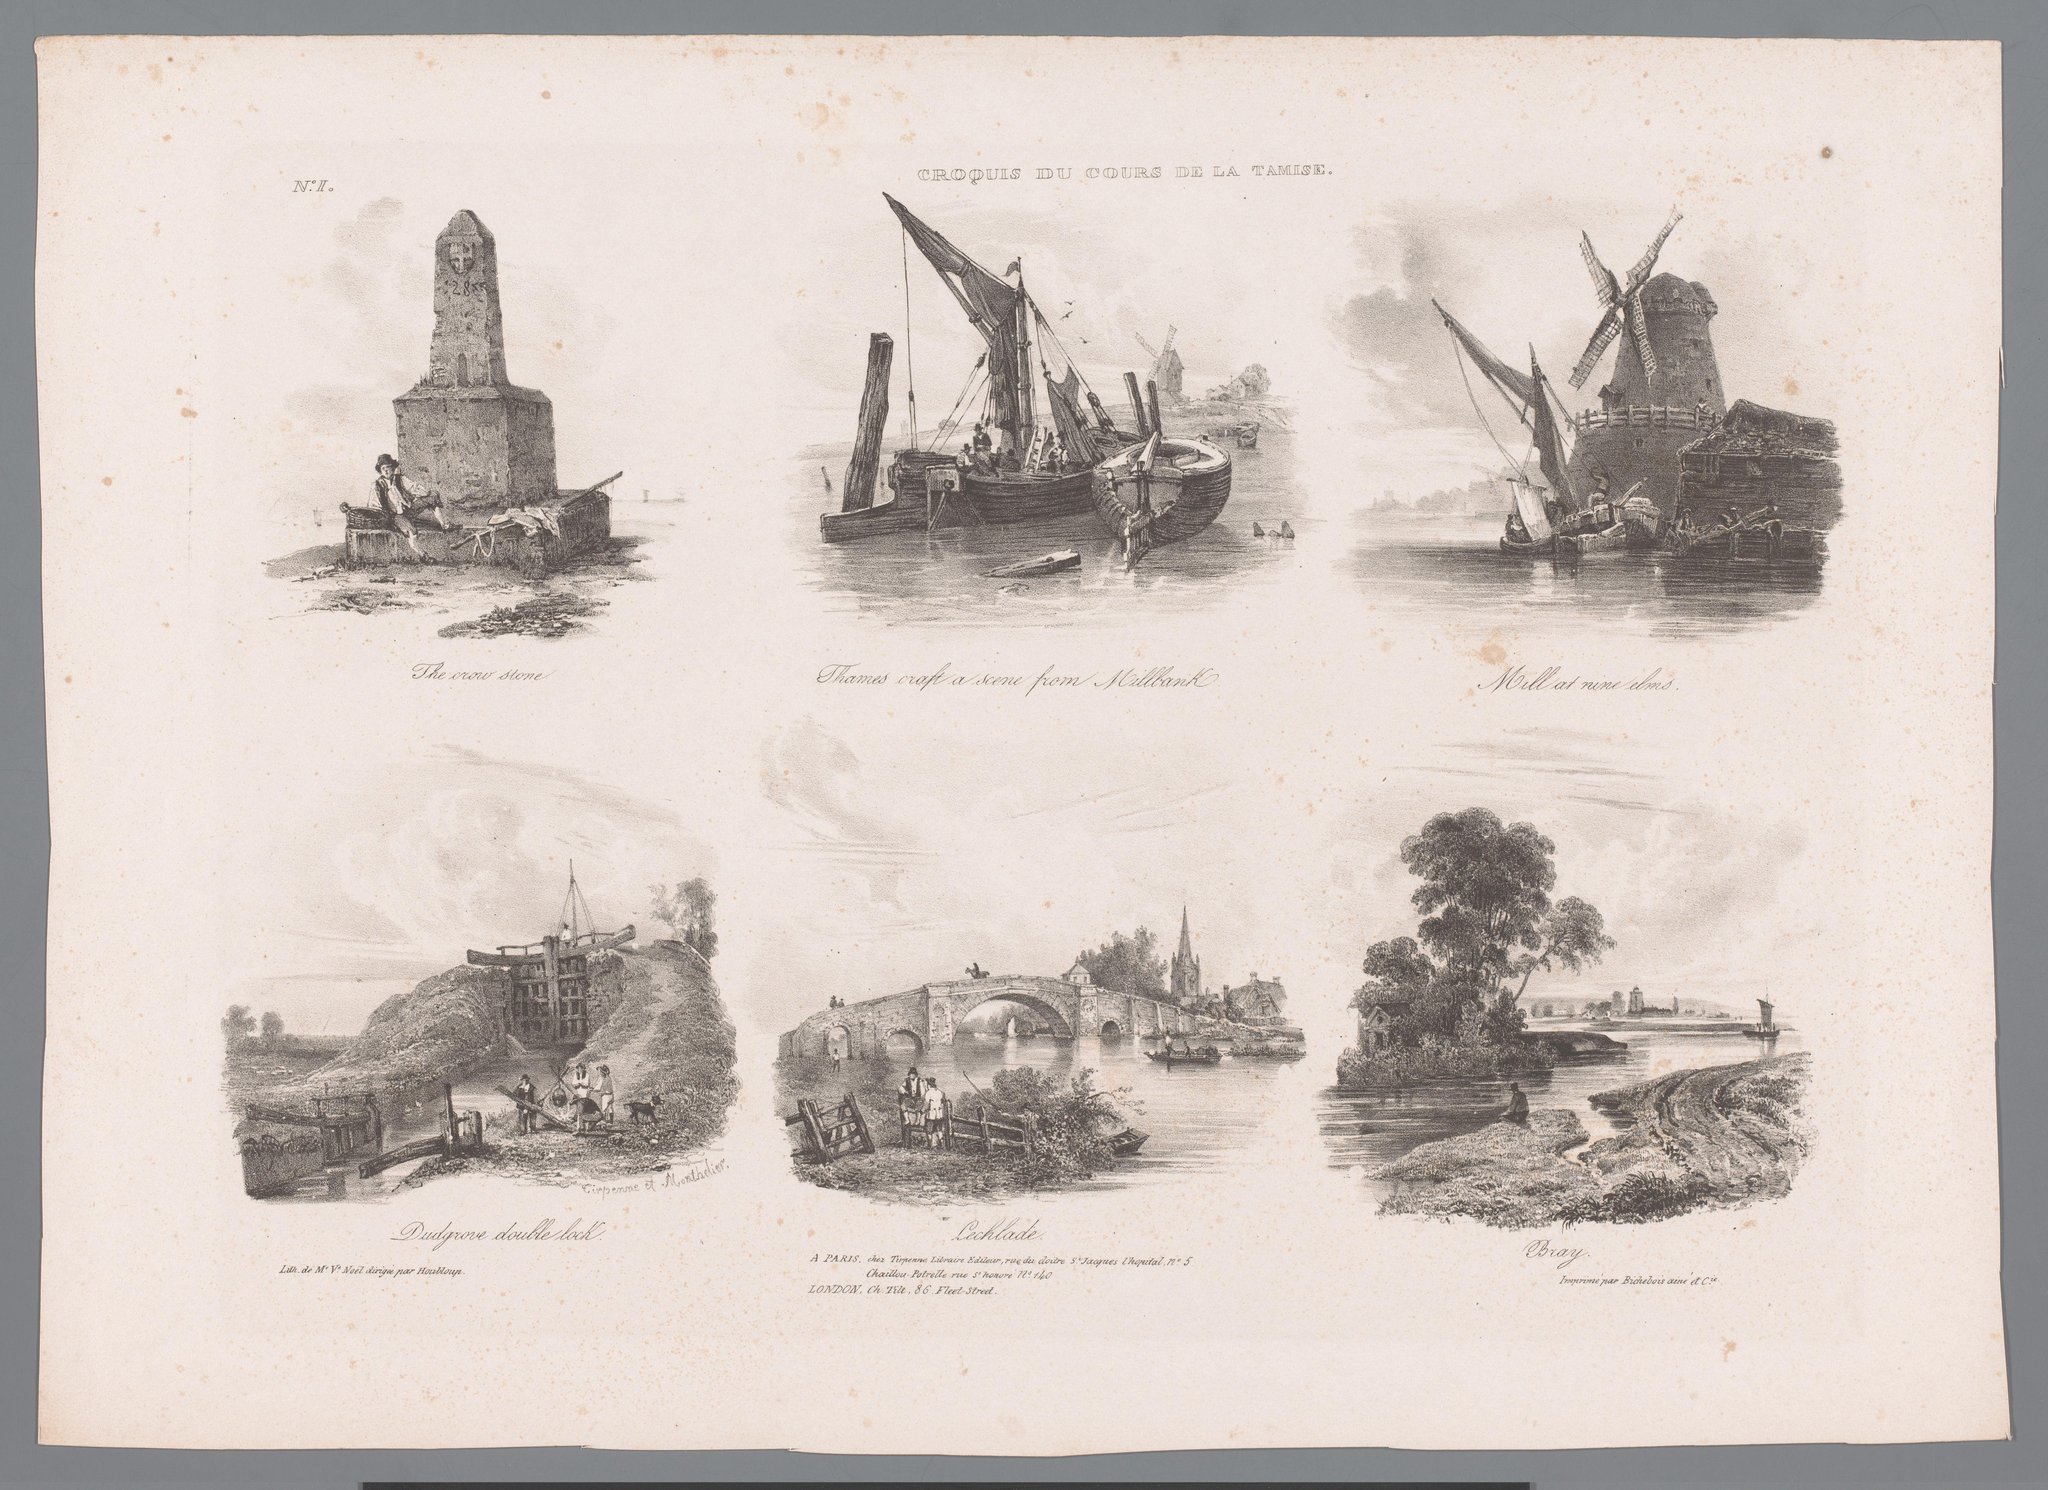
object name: print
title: Thames craft a scene from Millbank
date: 1830-1831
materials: paper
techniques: lithograph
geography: paris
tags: river, lift-lock, canal lock - hh - ideal landscapes, windmill in landscape, ships (in general) - cc - more than one ship, bridge, thames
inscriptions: collector's mark: Lugt 2228